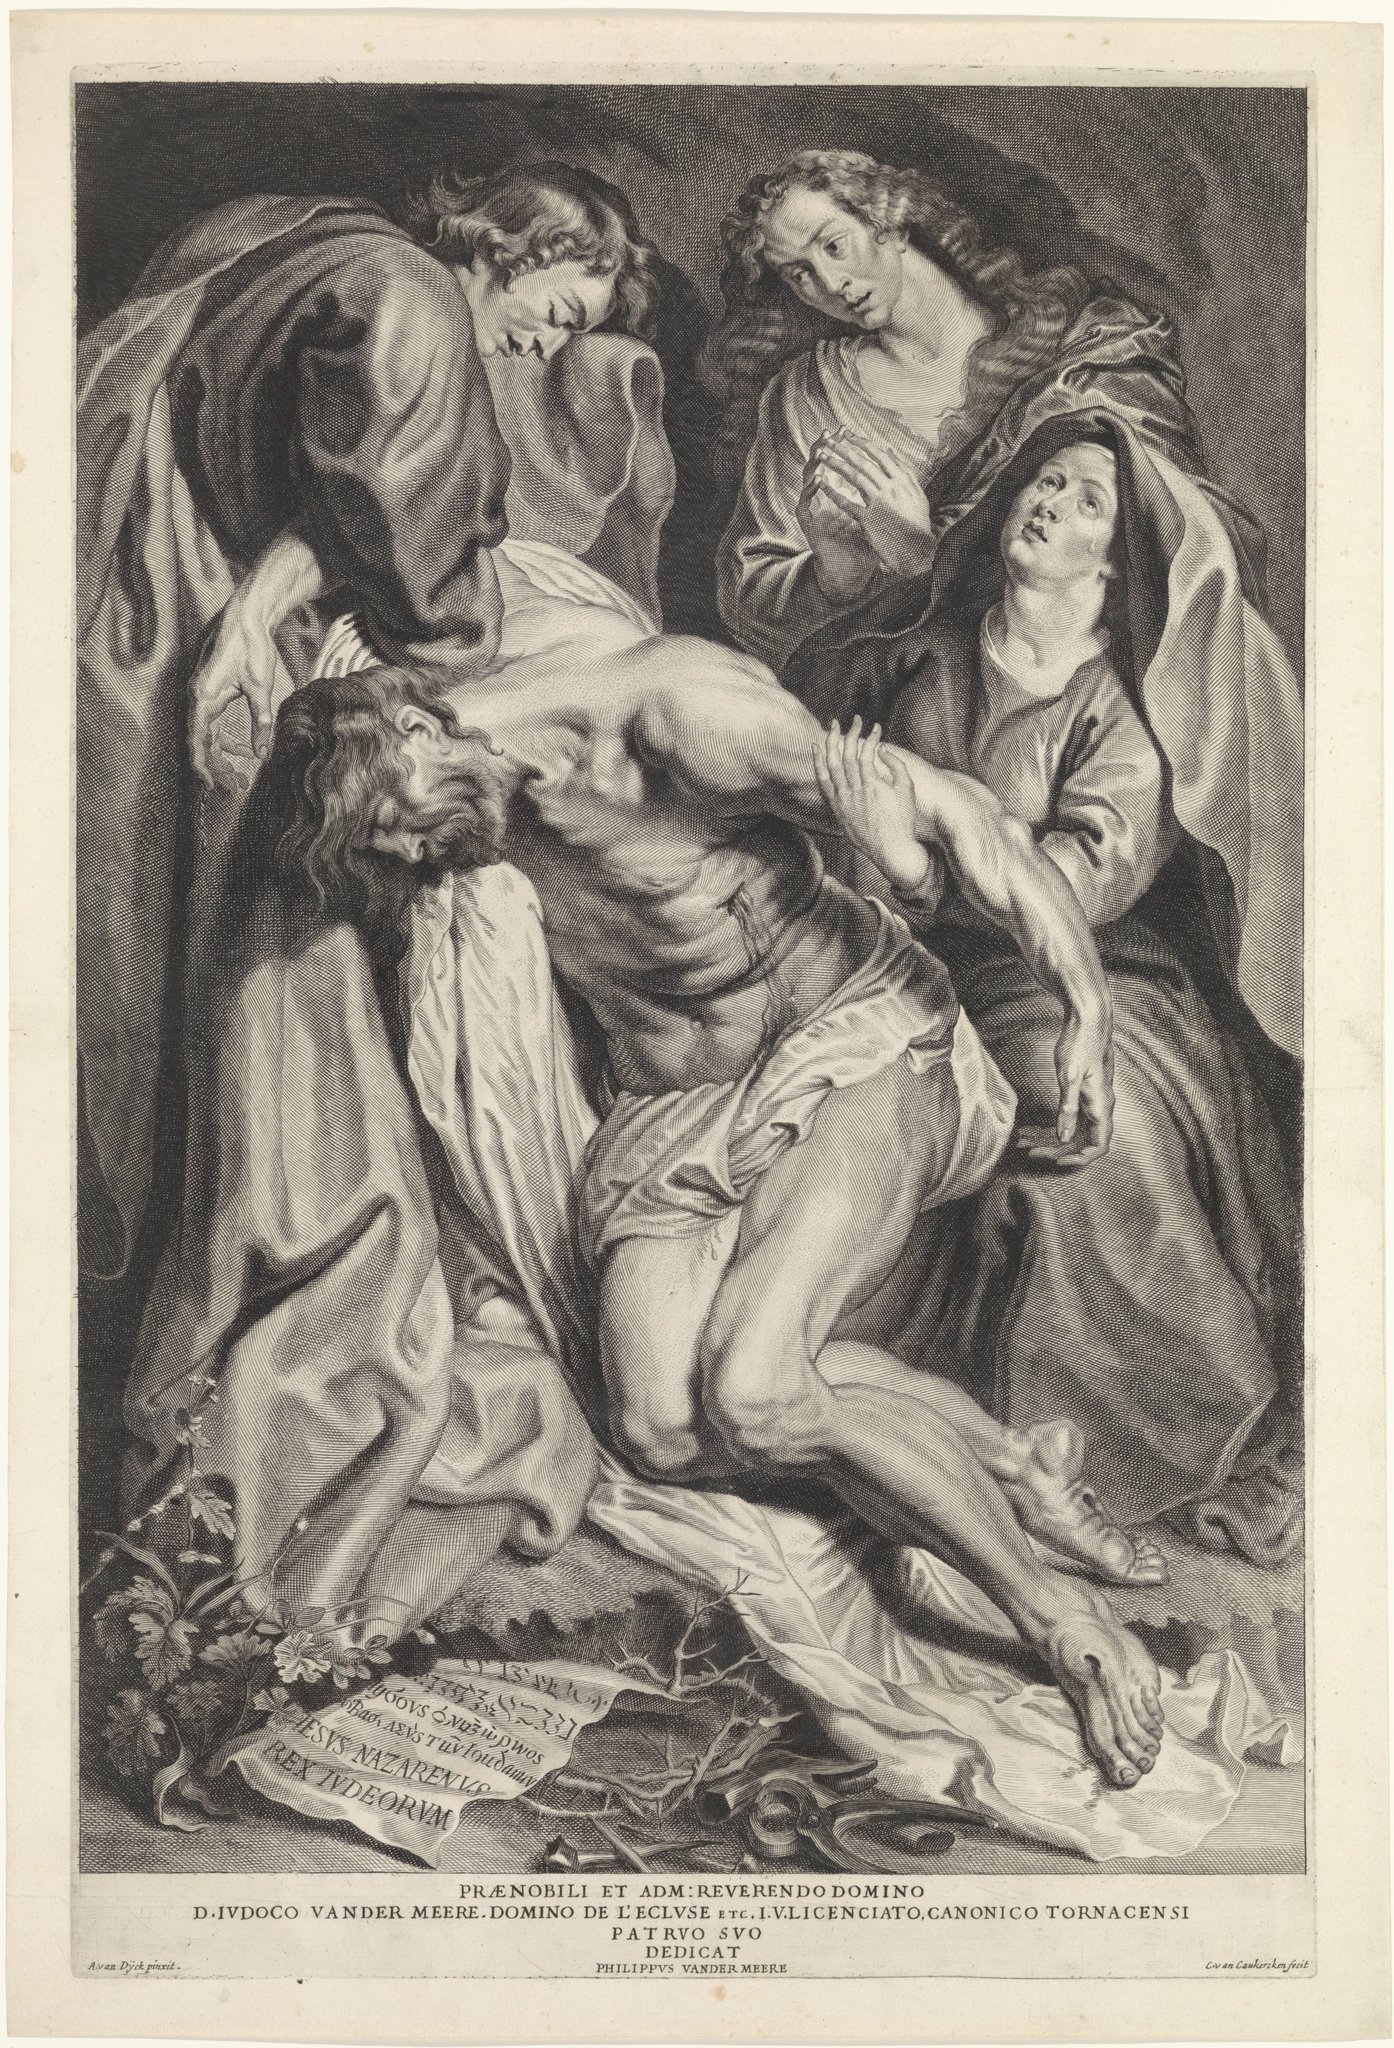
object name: print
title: Bewening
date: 1636-1680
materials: paper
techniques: engraving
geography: southern netherlands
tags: lamentation over the dead christ by his relatives and friends (christ usually without crown of thorns)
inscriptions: collector's mark: Lugt 240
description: Maria en Jozef van Arimatea houden het lichaam van Christus vast. Johannes de evangelist heeft zijn handen gevouwen om te bidden. Maria weent om haar dode zoon. Op de grond de doornenkroon en de tang en spijkers.